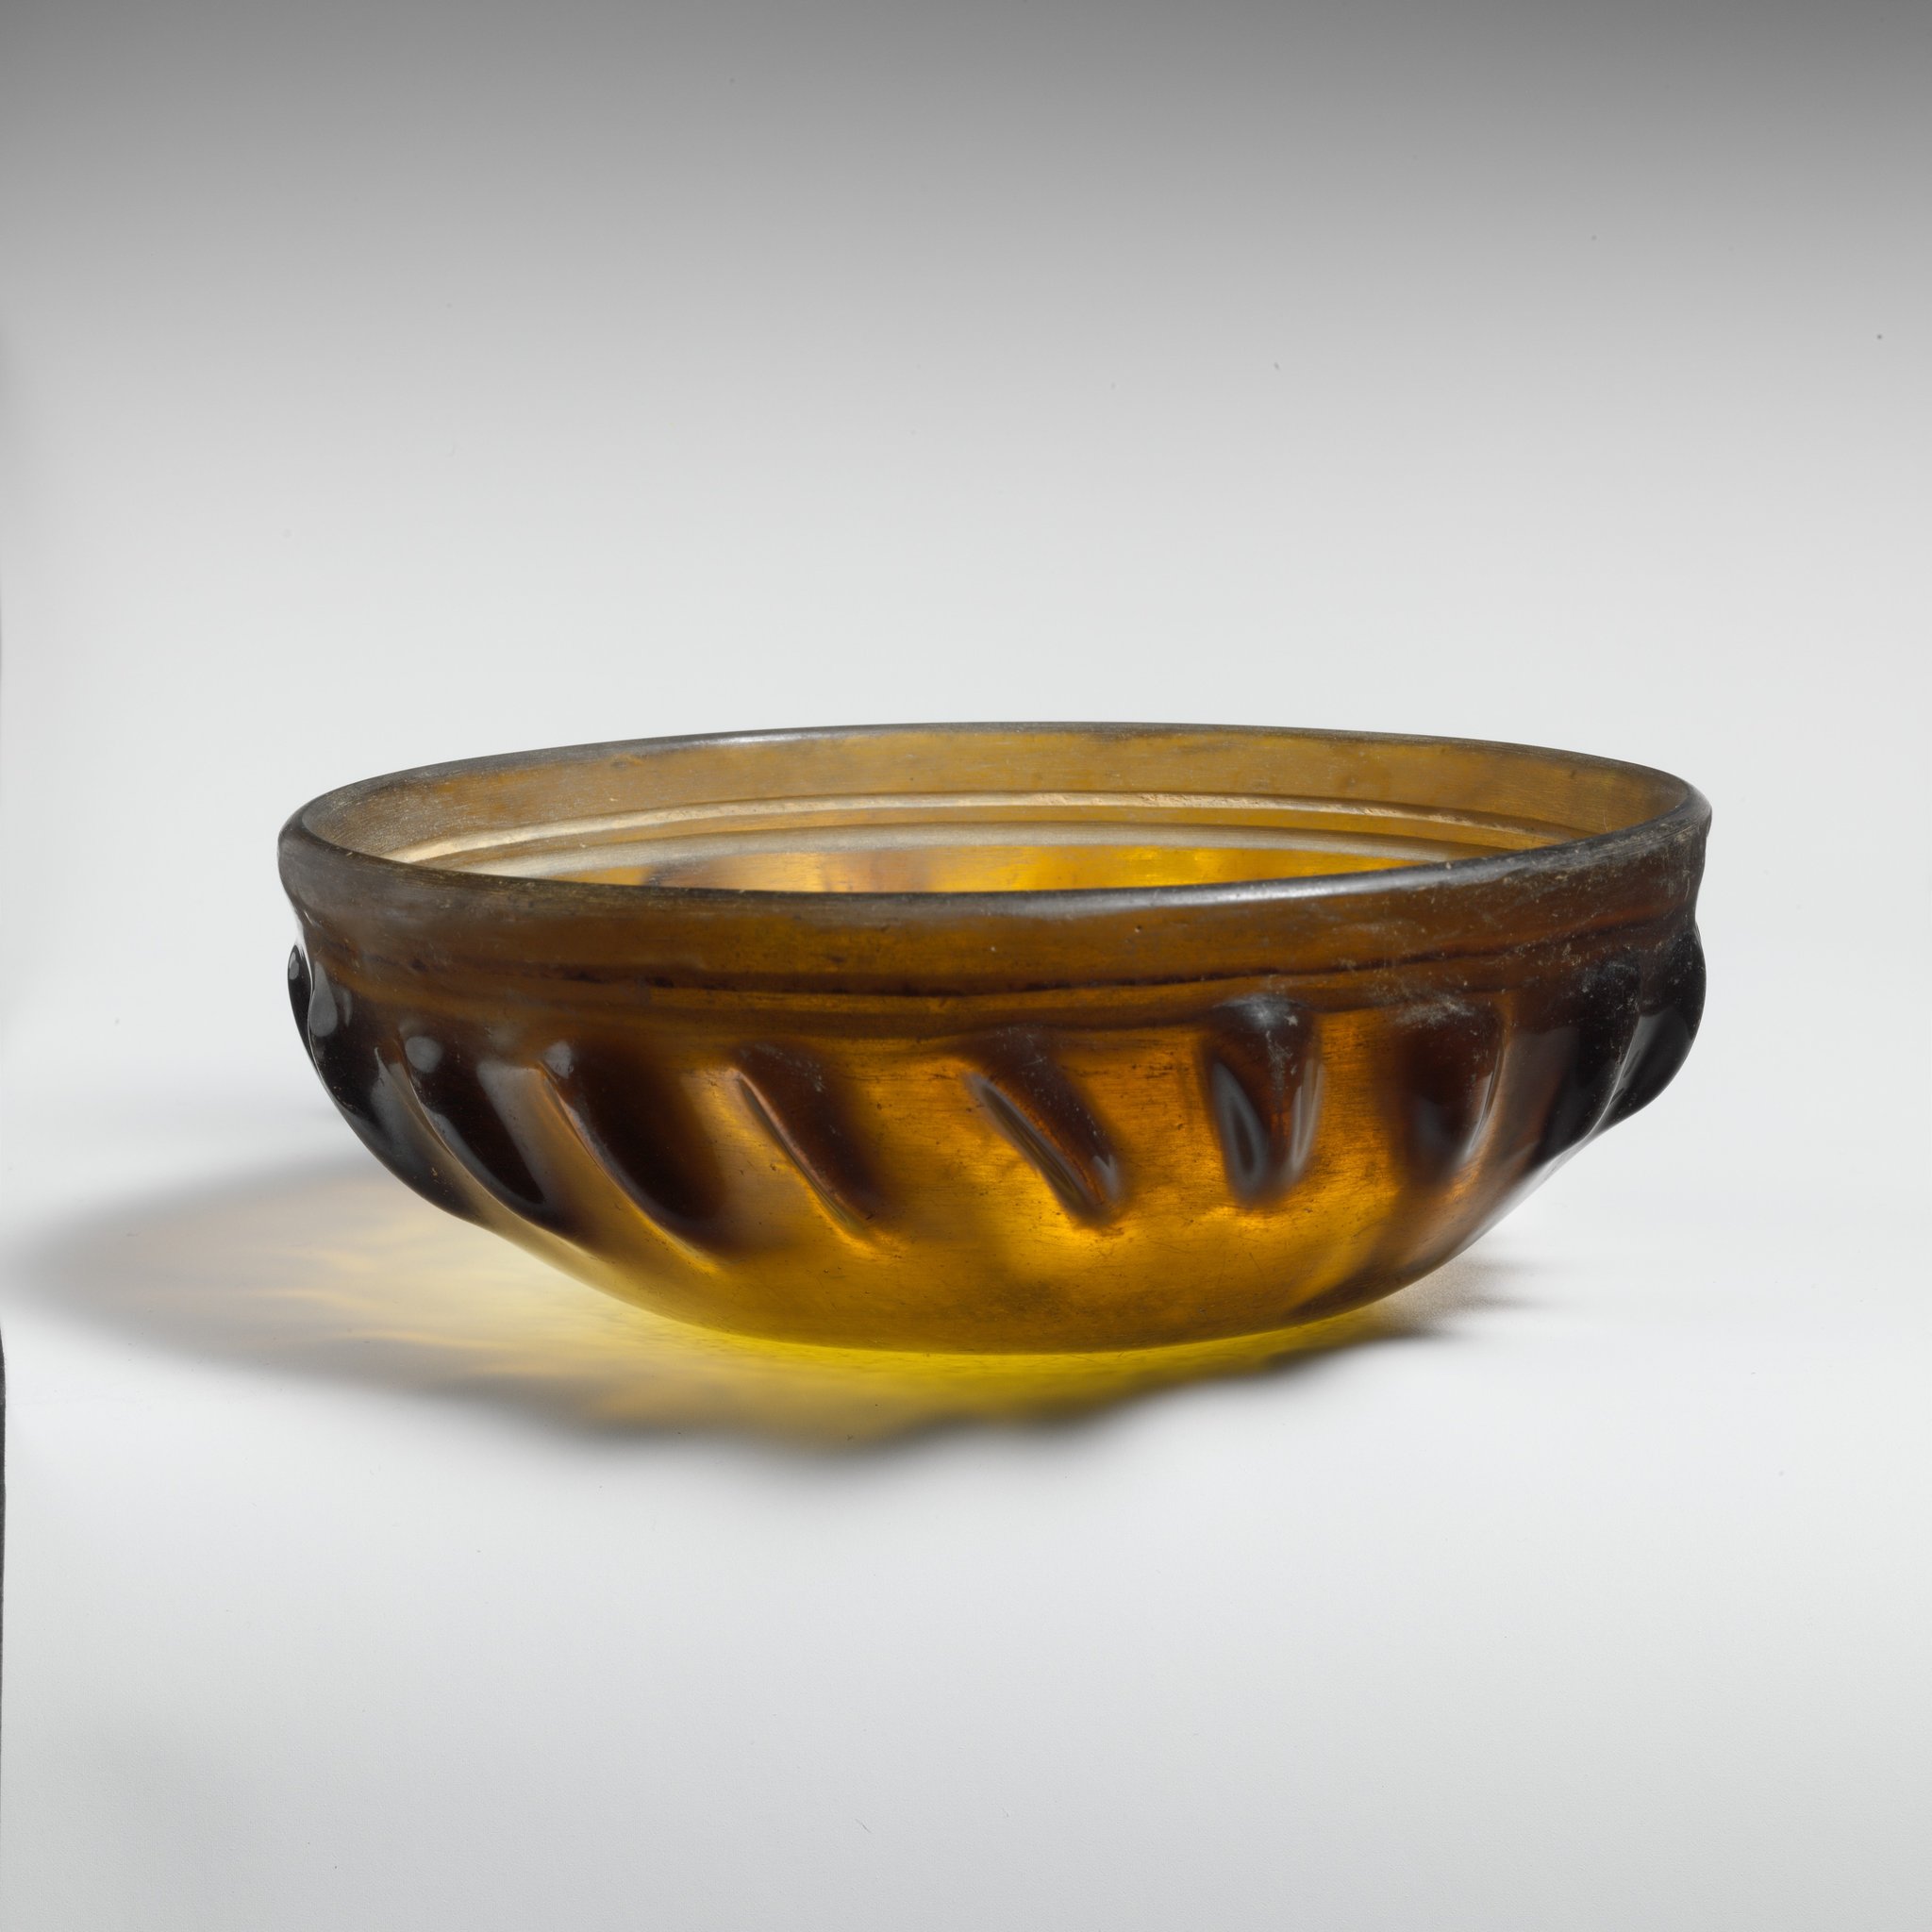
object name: bowl, ribbed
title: Glass ribbed bowl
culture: greek, eastern mediterranean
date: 100-1 BCE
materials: glass